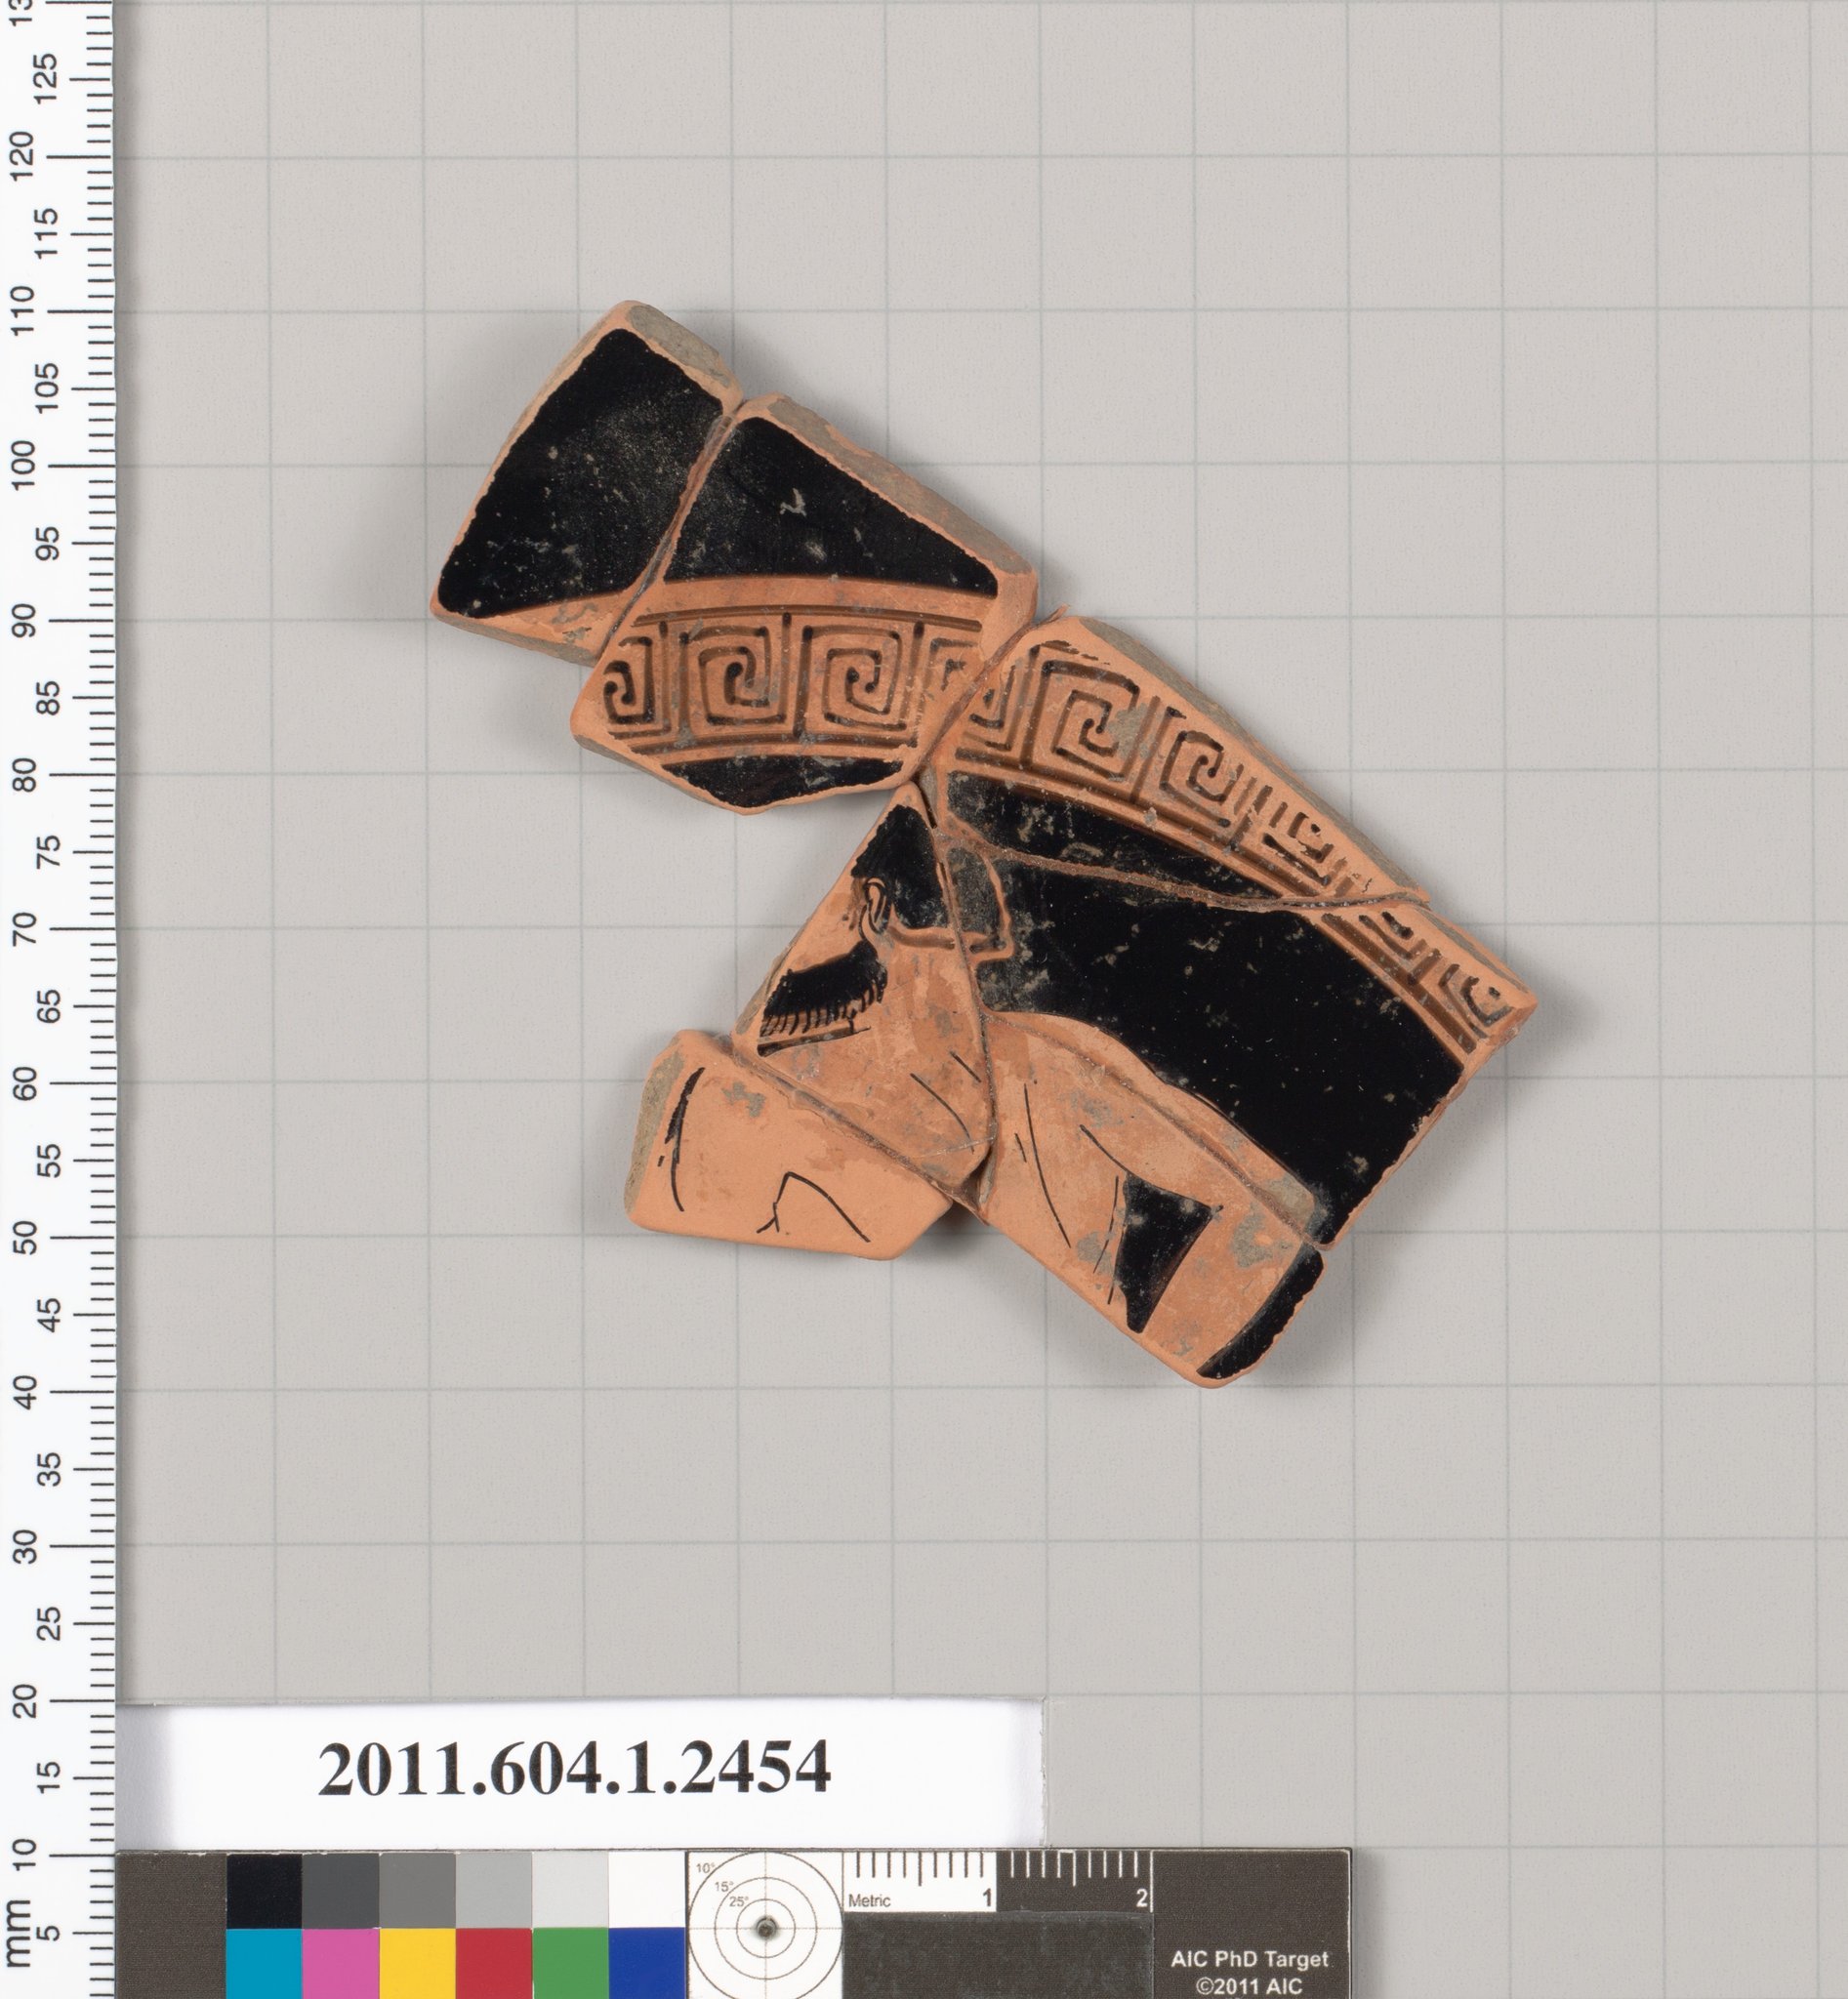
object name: kylix fragment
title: Terracotta fragment of a kylix (drinking cup)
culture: greek, attic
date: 500-480 BCE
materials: terracotta